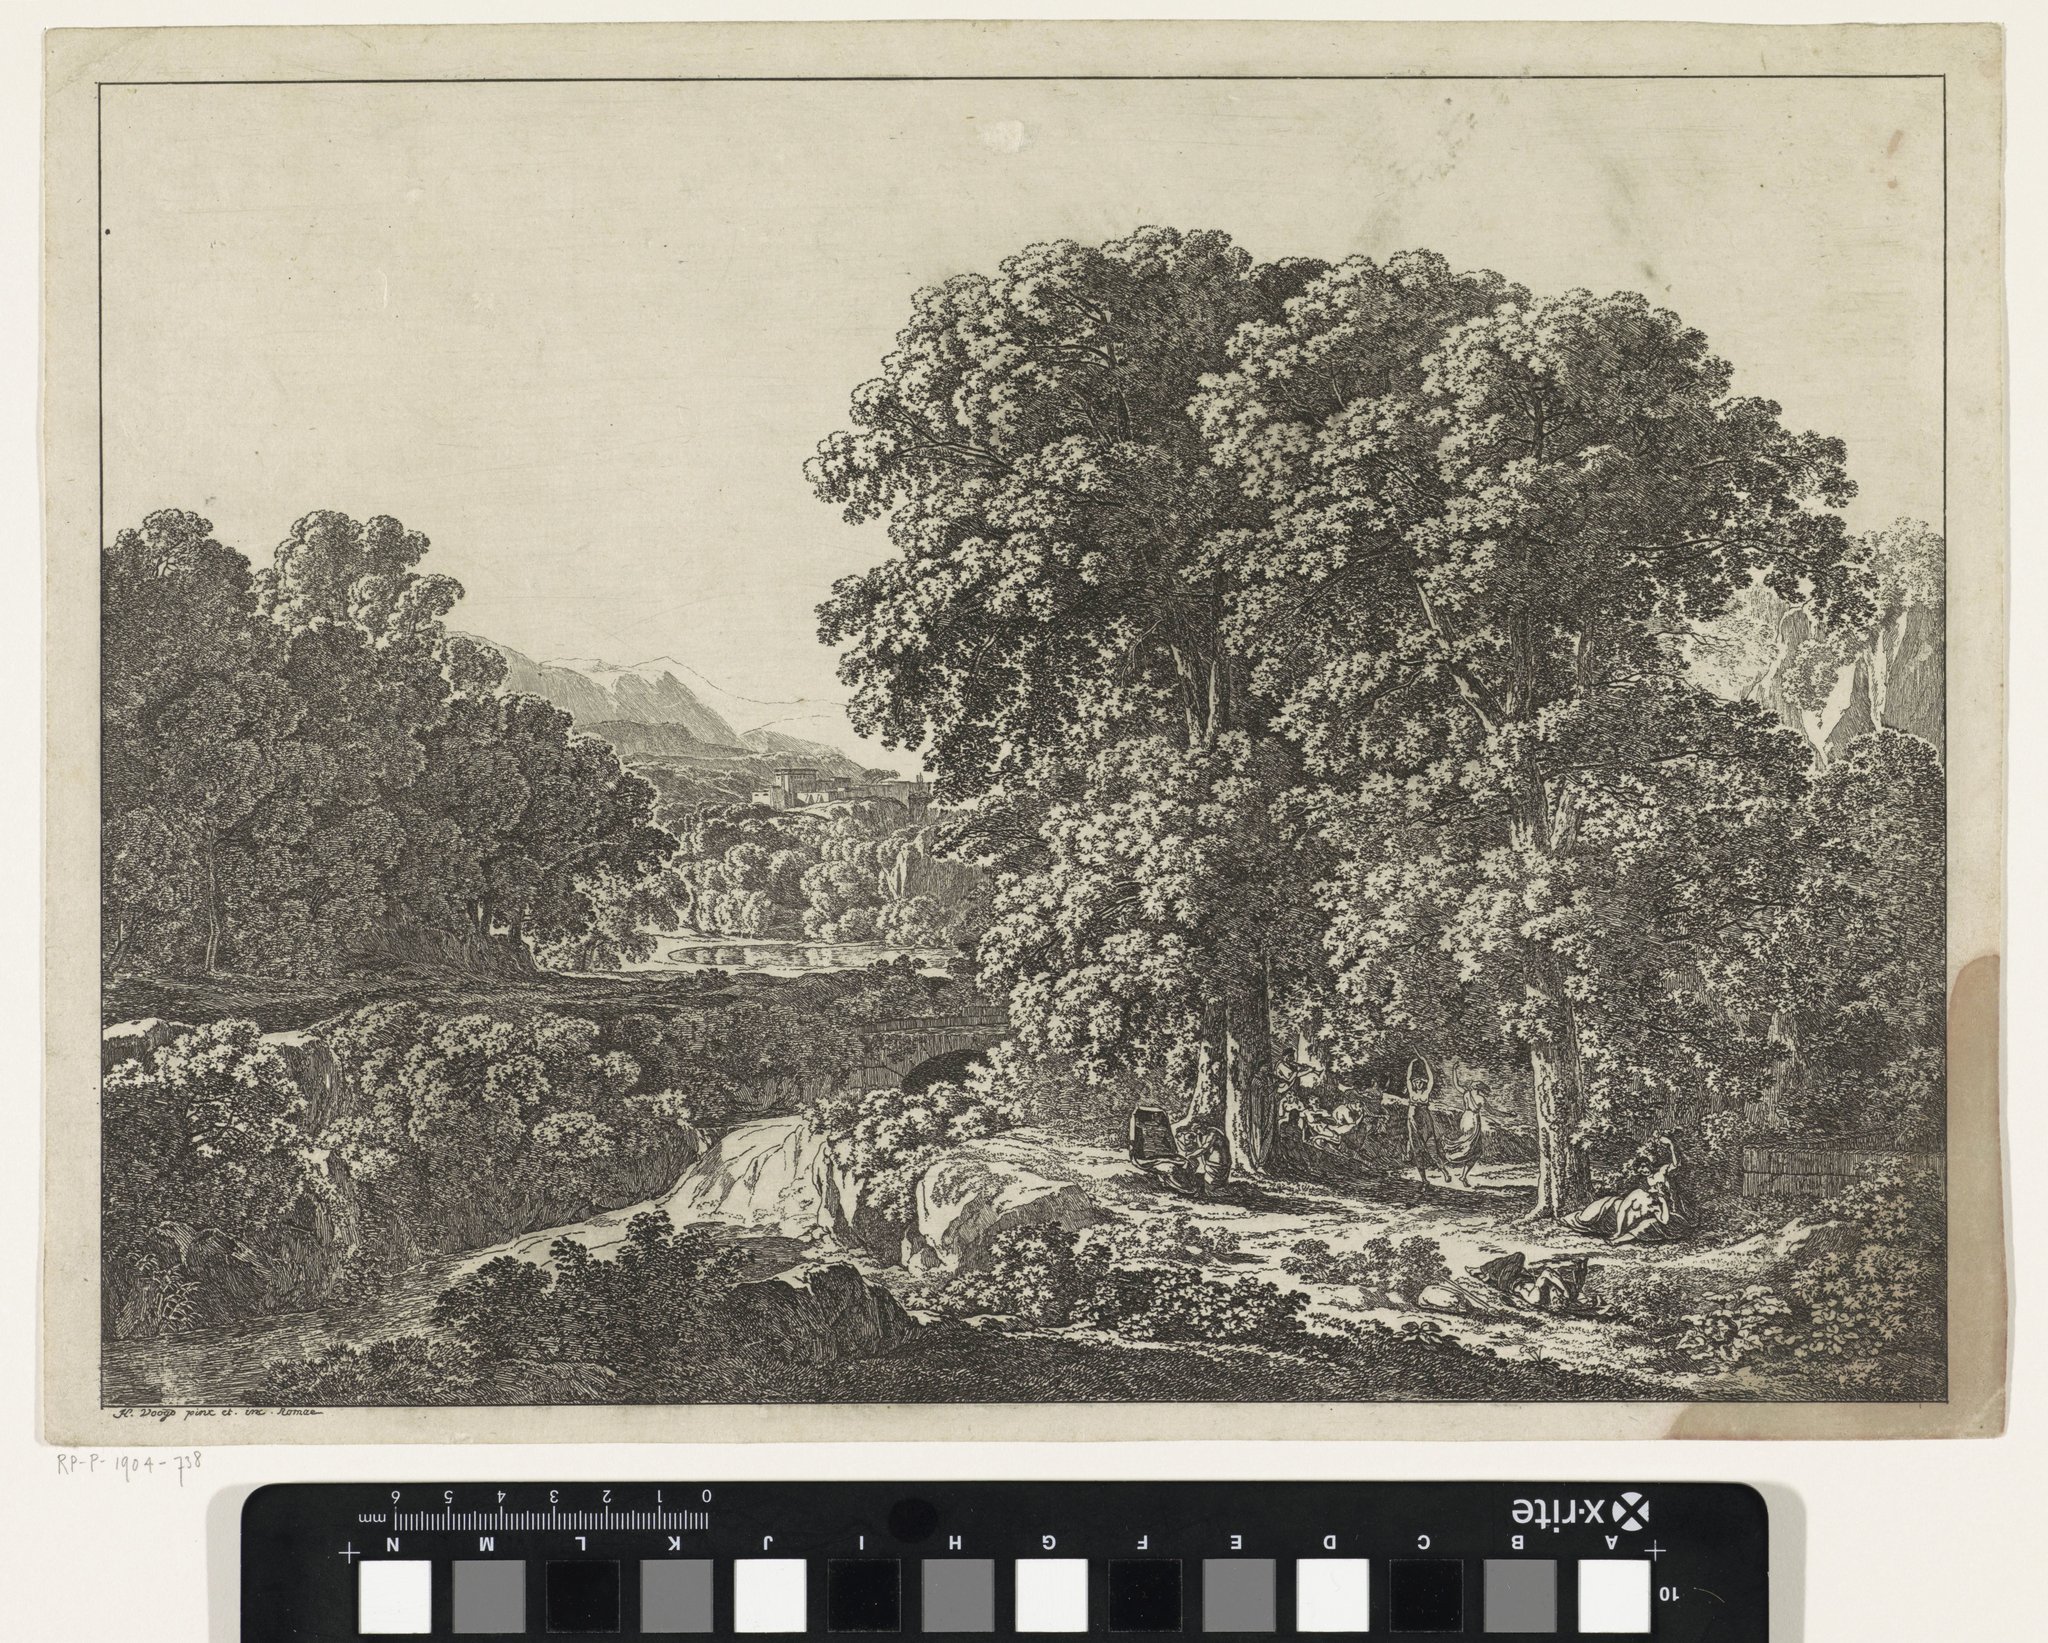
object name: print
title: Arcadisch landschap met dansende herderinnen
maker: hendrik voogd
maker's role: draughtsman, painter, print maker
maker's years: 1768-1839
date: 1788-1839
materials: paper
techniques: etching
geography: rome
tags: trees, dancing, pastorals, arcadian scenes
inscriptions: collector's mark: Lugt 2228